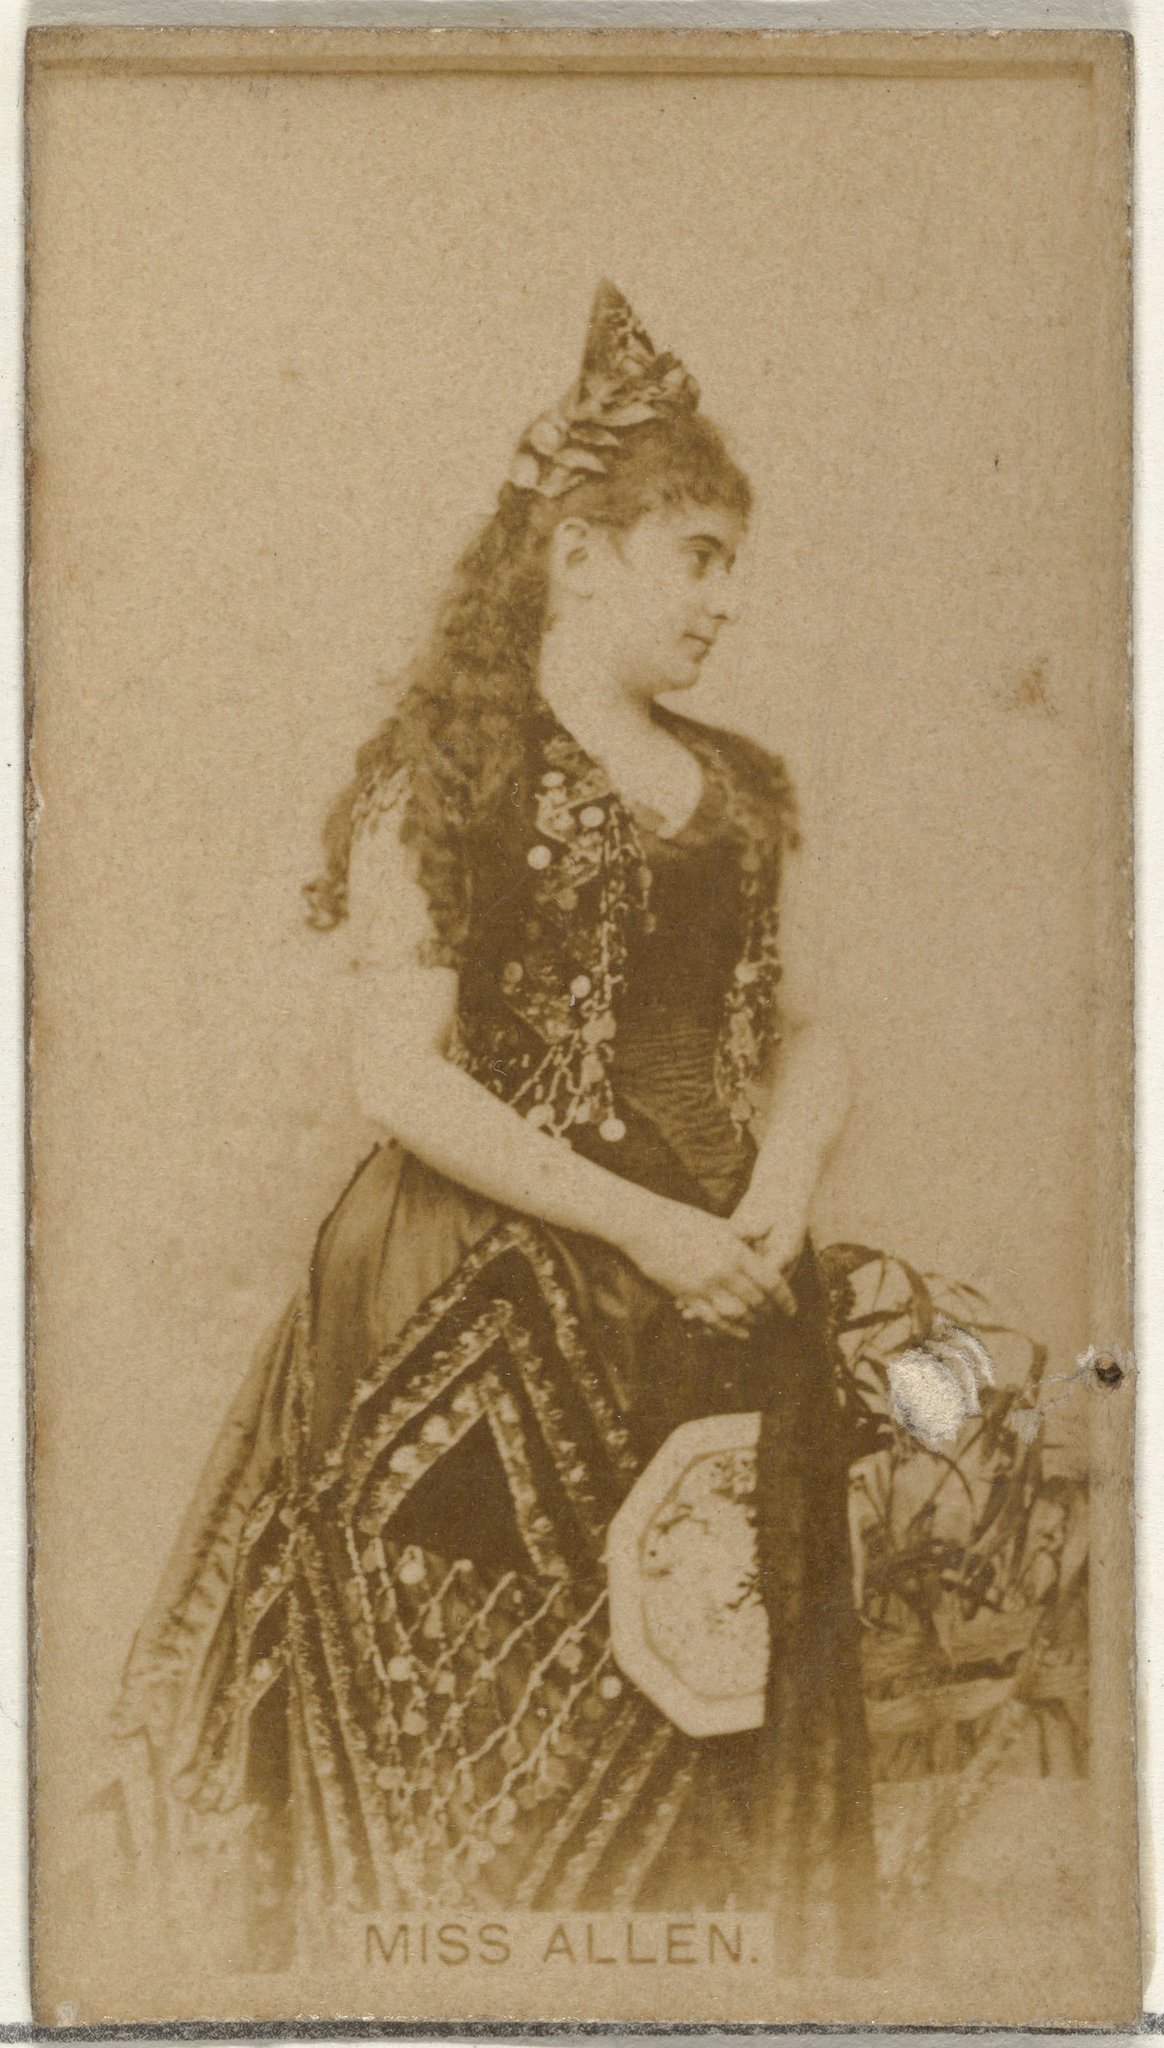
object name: photograph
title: Miss Allen, from the Actors and Actresses series (N145-8) issued by Duke Sons & Co. to promote Duke Cigarettes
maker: w. duke, sons & co.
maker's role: publisher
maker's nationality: american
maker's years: 1870-1920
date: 1891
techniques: albumen silver print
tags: portraits,women,actresses